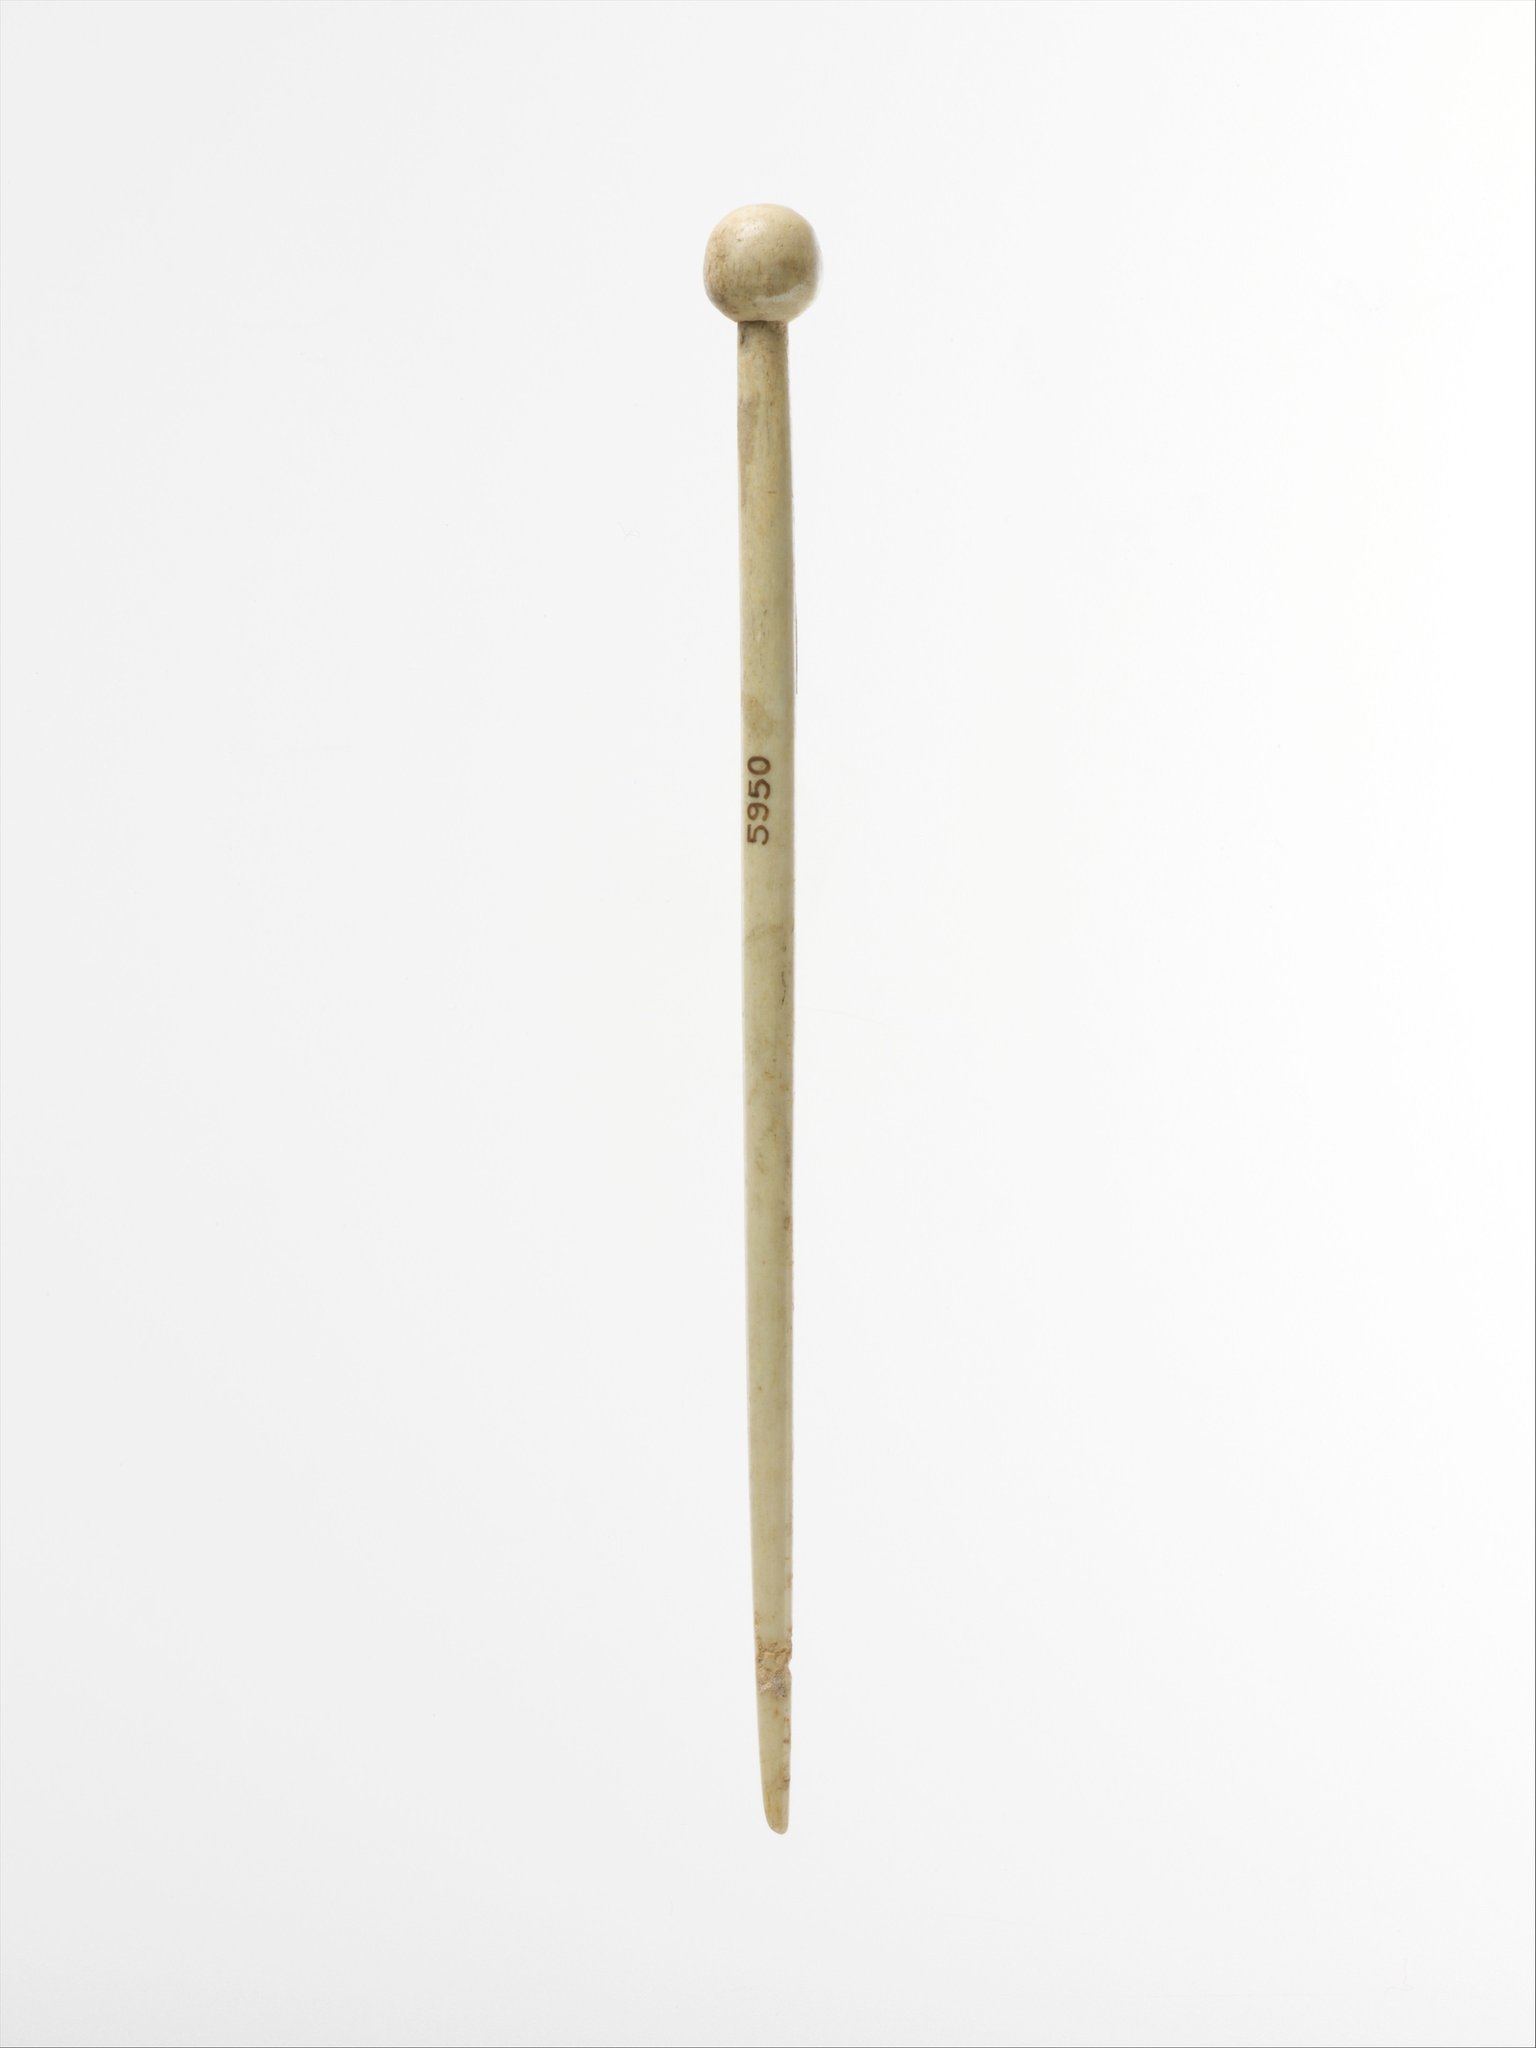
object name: pin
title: Bone hairpin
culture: roman, cypriot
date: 1-200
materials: bone